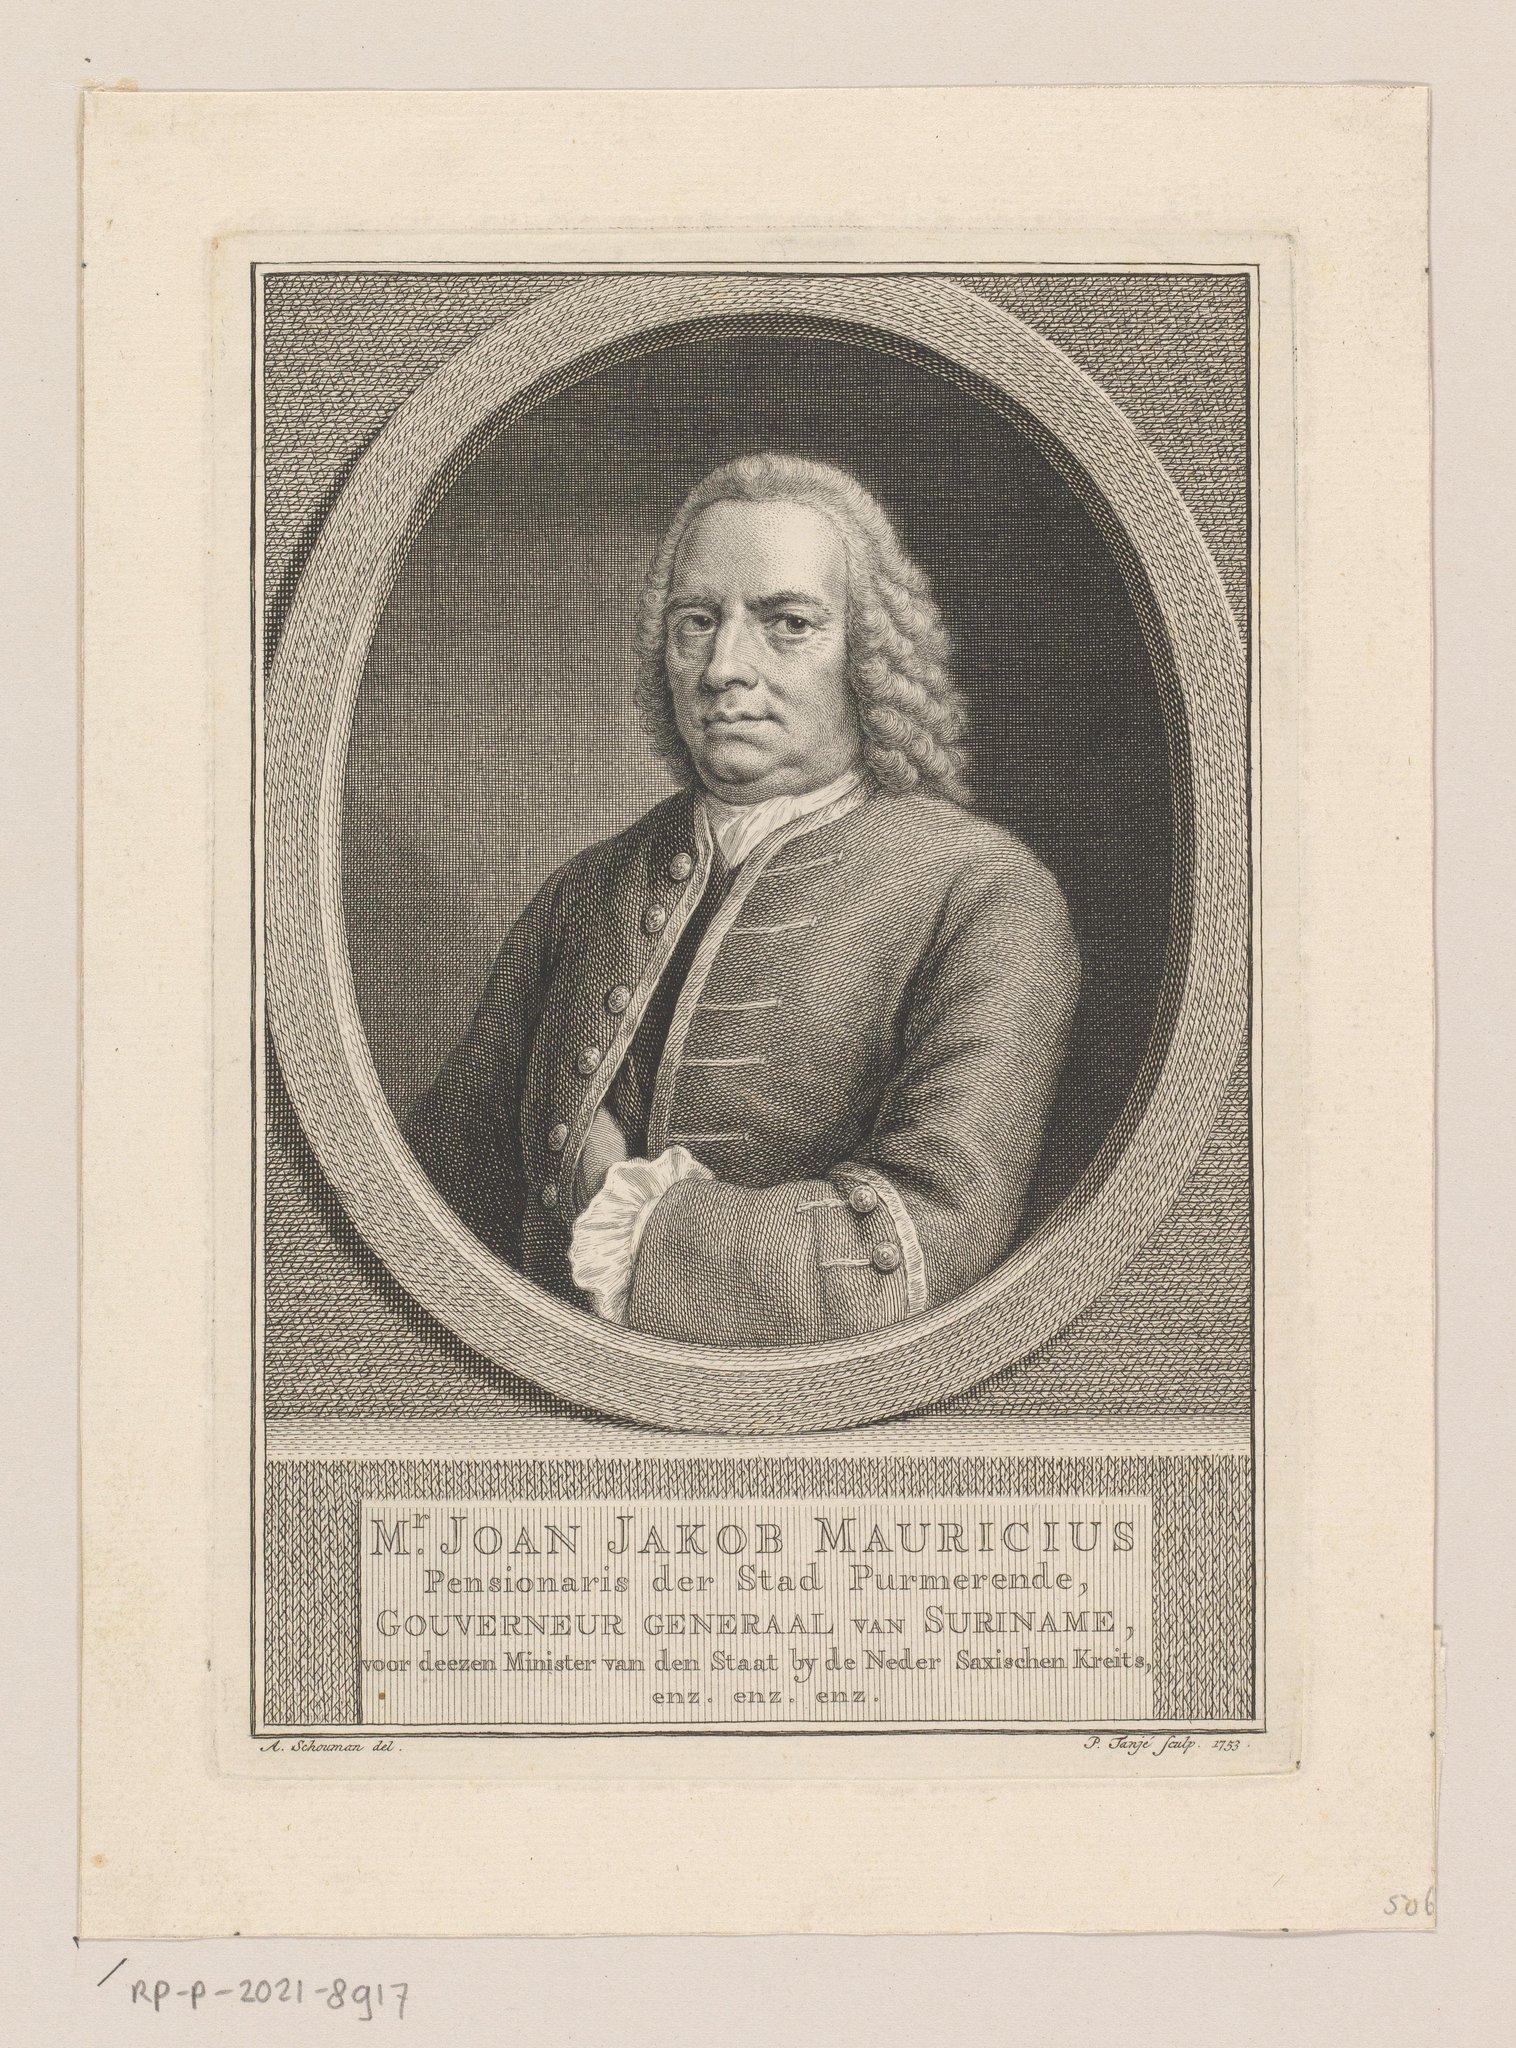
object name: book illustration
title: Portret van Jan Jacob Mauricius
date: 1753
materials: paper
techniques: engraving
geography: amsterdam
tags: joan jacob mauricius, ornament ~ medallion, historical persons, portrait of a writer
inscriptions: date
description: Prent waarschijnlijk uit: Mauricius, Jan Jacob. Dichtlievende uitspanningen. Amsterdam: weduwe S. Schouten en Gerret de Groot, 1753.